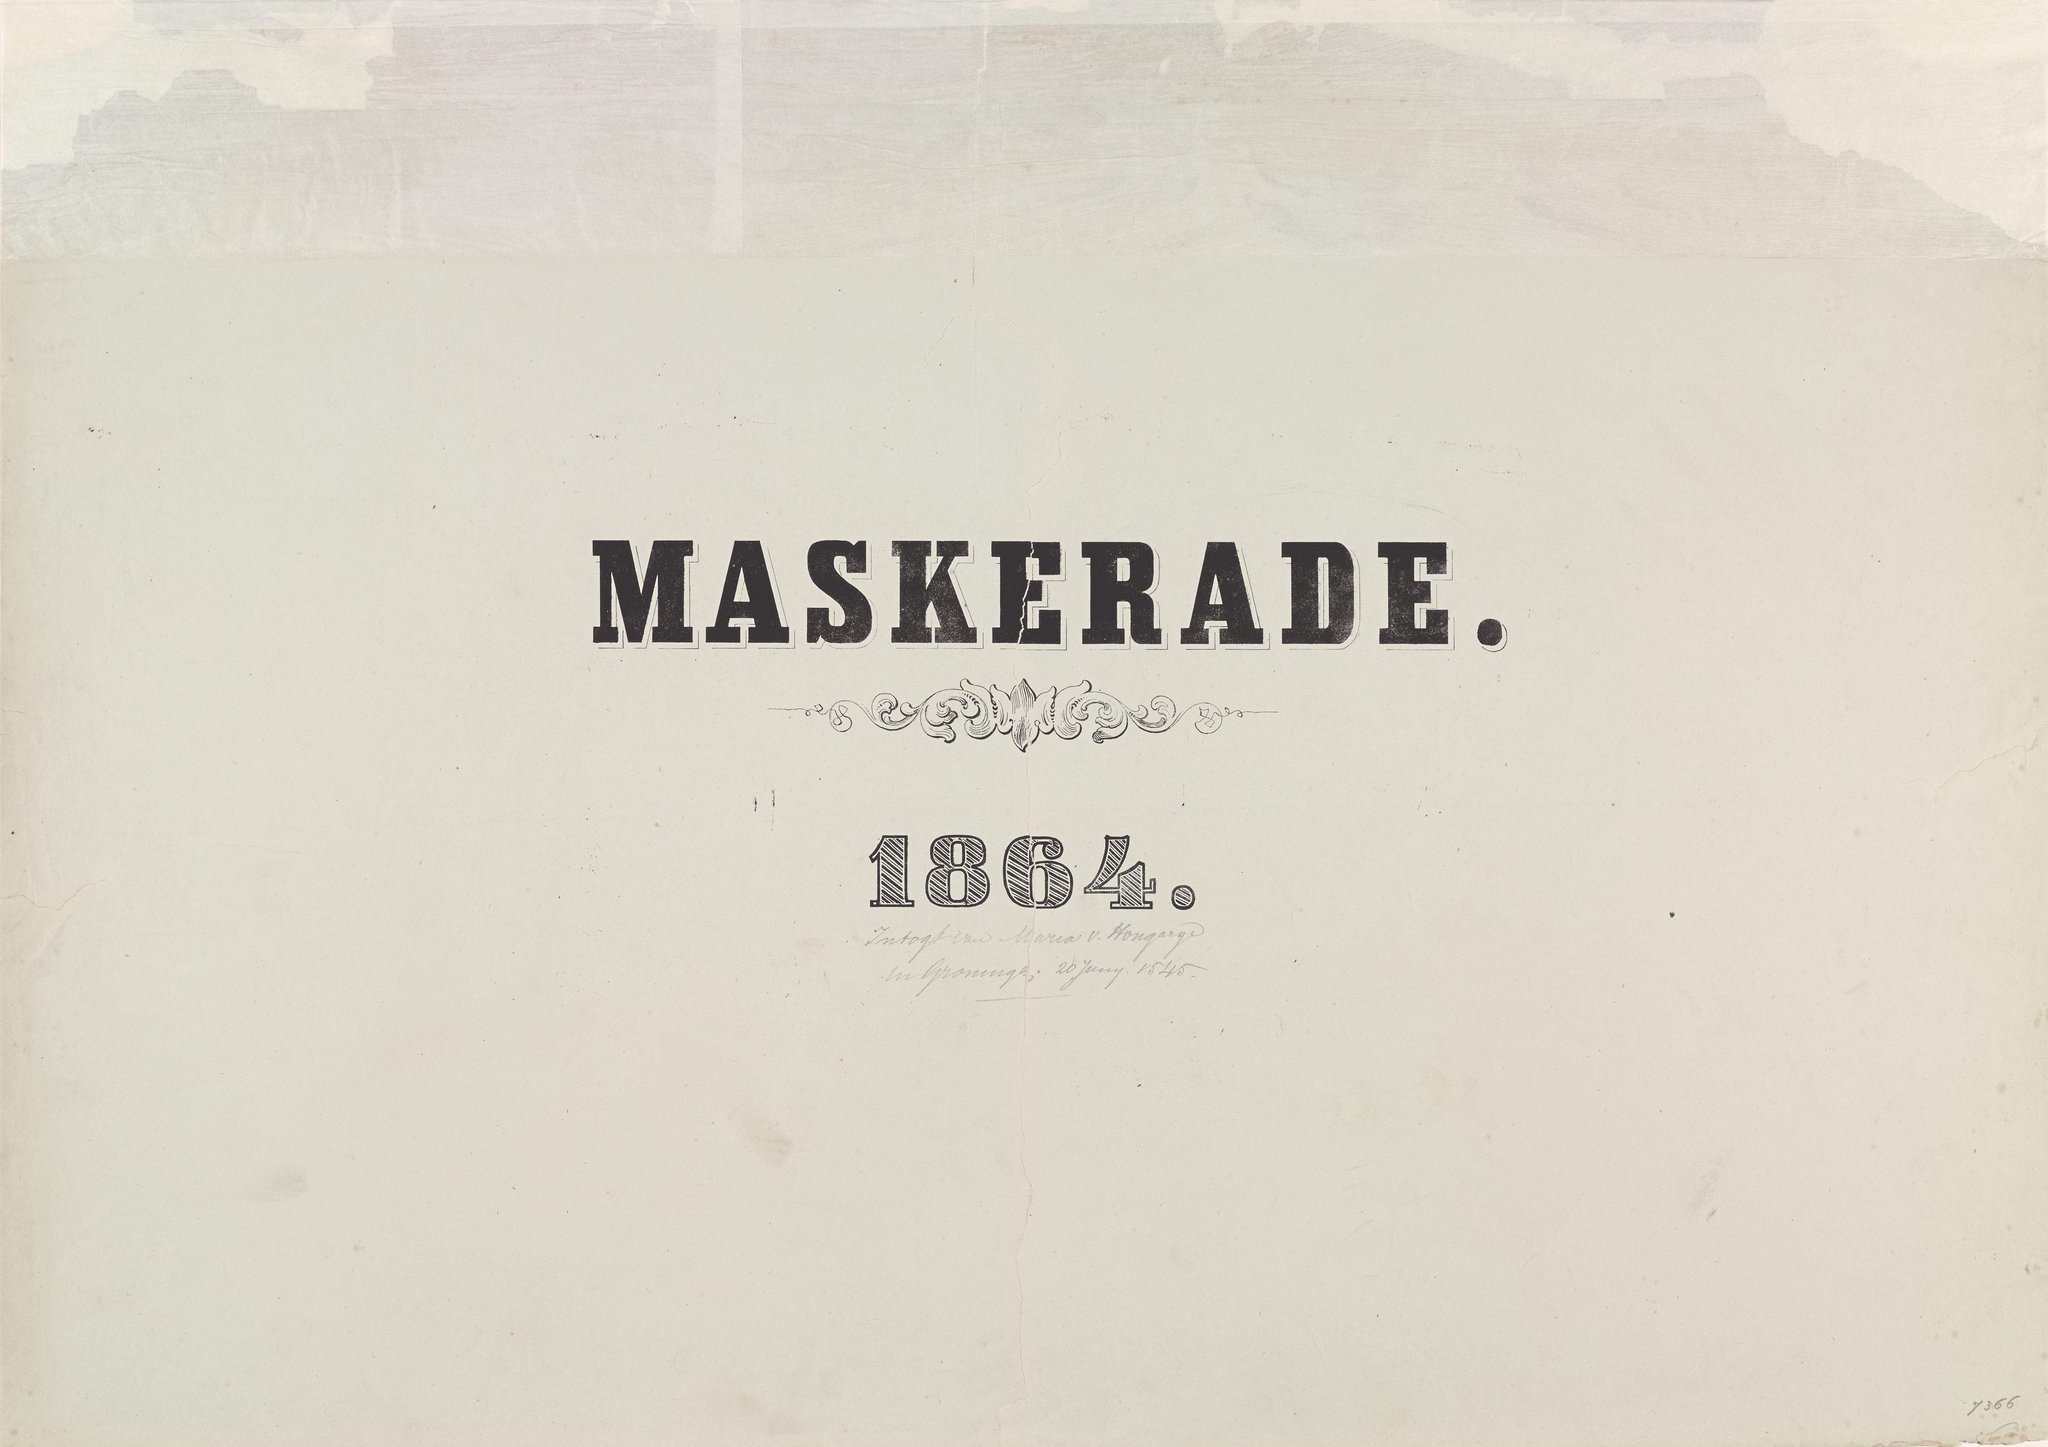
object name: folder container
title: Omslag voor de prenten van de Groningse maskerade, 1864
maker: johannes hermanus van de weijer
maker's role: print maker, printer, publisher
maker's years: 1817-1889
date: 1864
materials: paper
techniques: lithograph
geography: groningen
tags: brussels, maria van hongarije (landvoogdes der nederlanden), students' pageant, costumes used in pageants, commemoration of the founding of a university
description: Omslag voor de vier platen plus verklaring van de gekostumeerde optocht georganiseerd door de studenten van de Hogeschool van Groningen op 14 september 1864, ter viering van het 250-jarig bestaan van de hogeschool, voorstellende de intocht van Maria van Hongarije in Groningen op 20 juni 1545. Dubbelgevouwen blad bedrukt op voorzijde met de titel en een vignet.